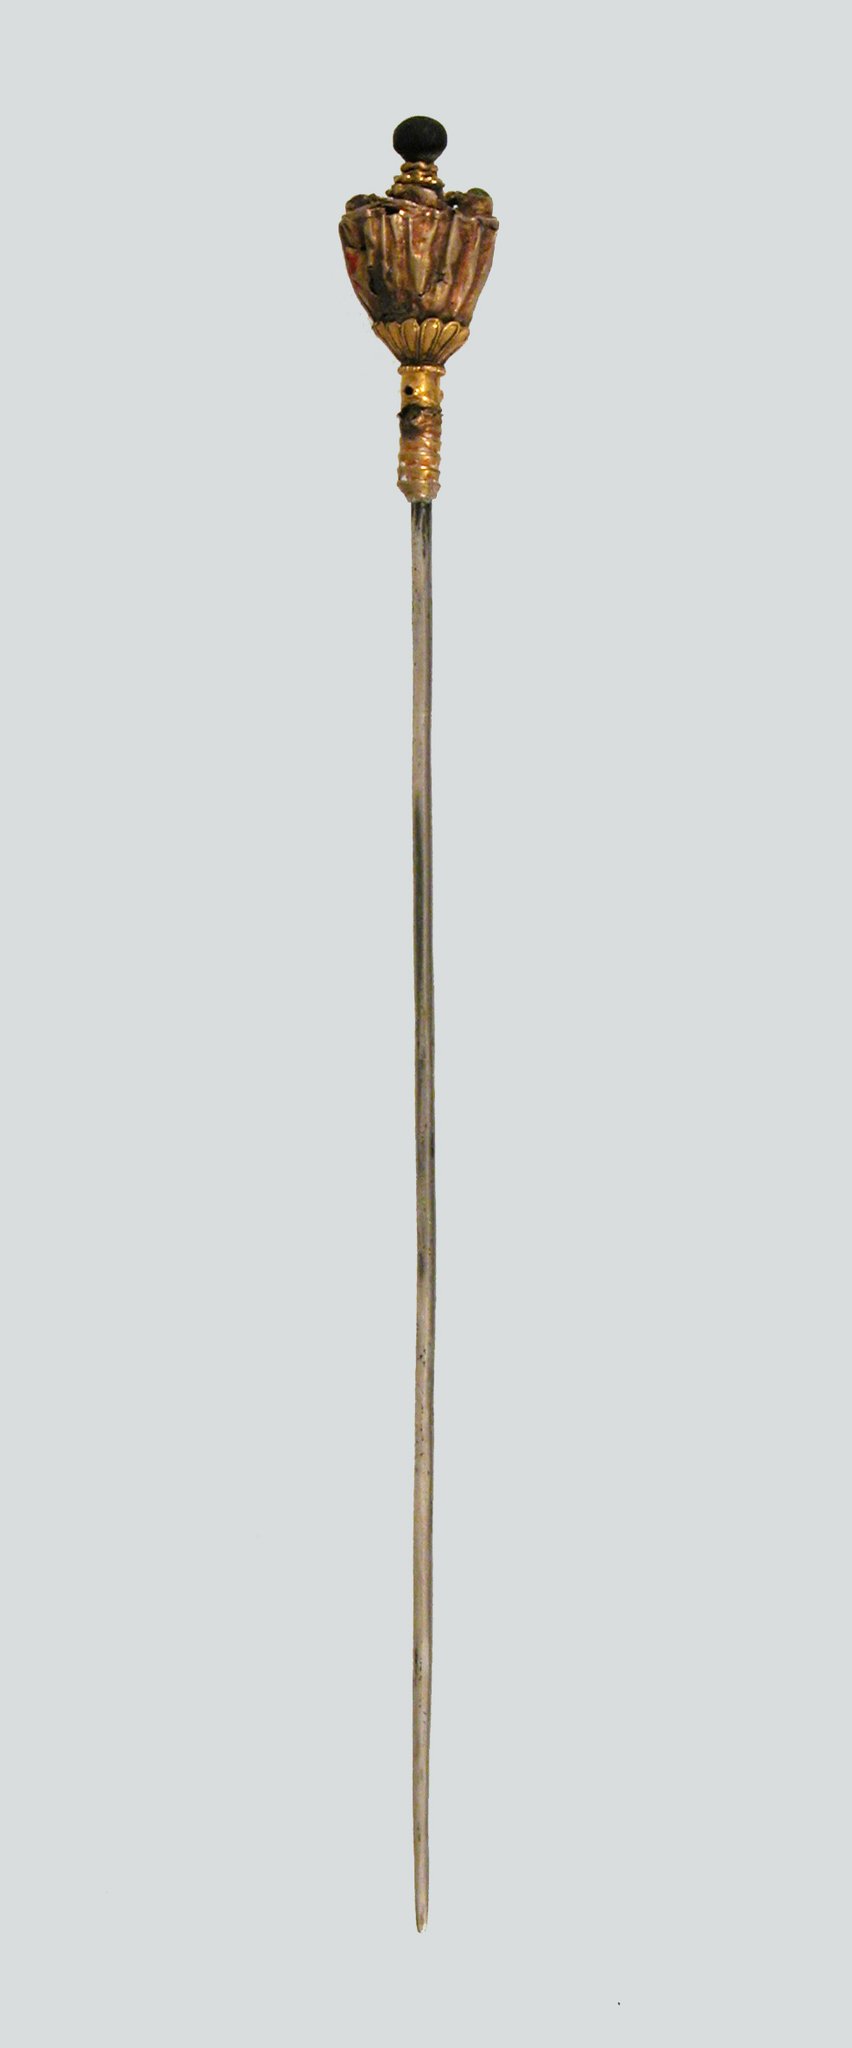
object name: hairpin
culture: frankish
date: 501-600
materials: gold foil, paste, silver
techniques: filigree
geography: northern france